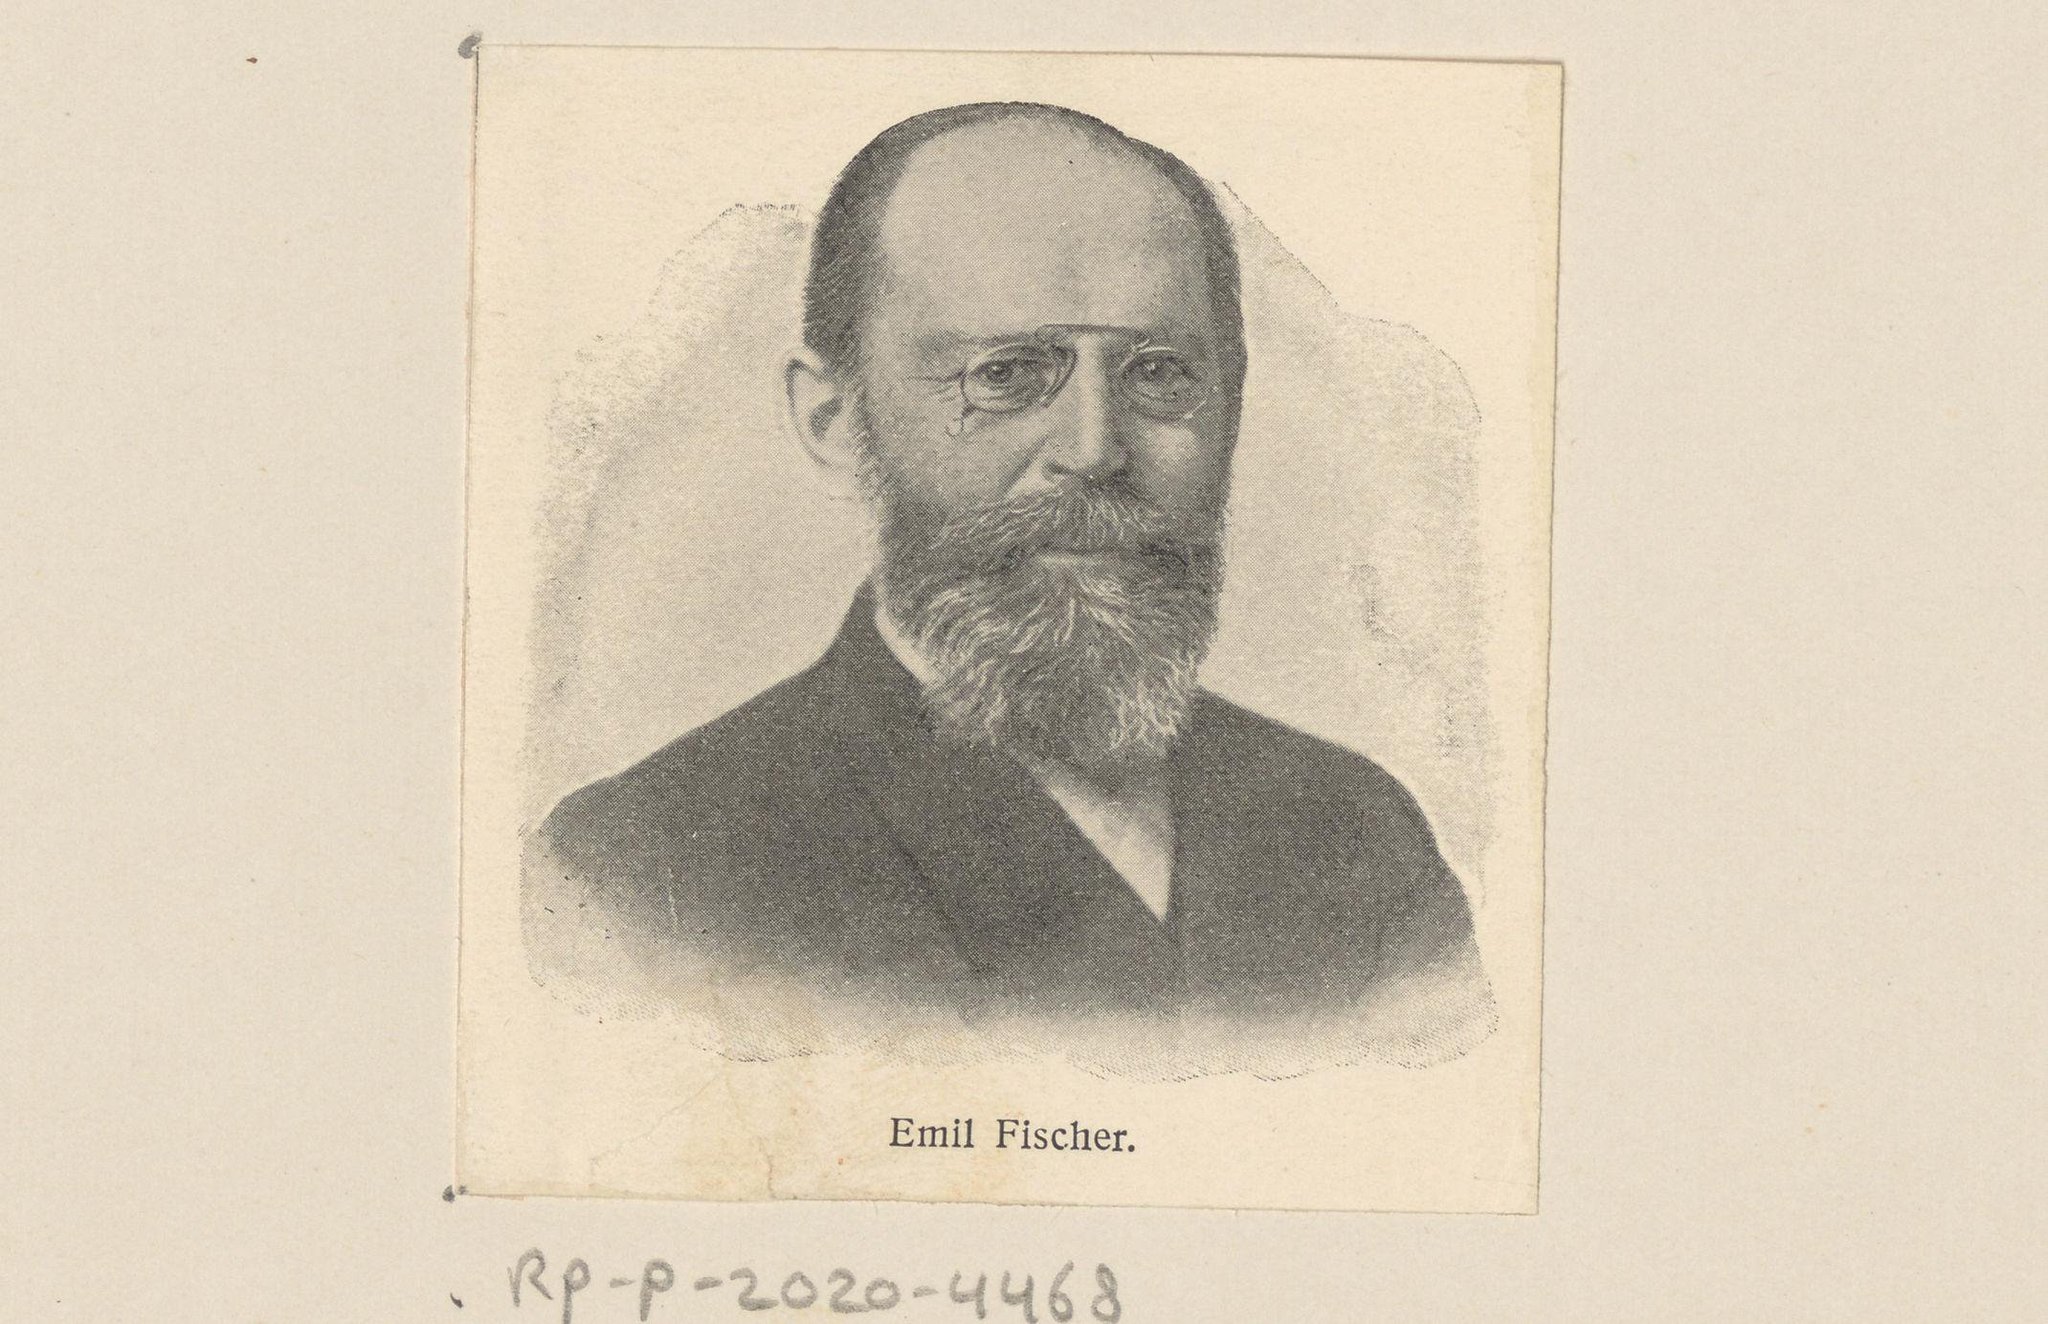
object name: photomechanical print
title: Portret van Hermann Emil Fischer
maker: Anonymous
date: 1895-1900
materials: paper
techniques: autotype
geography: germany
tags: historical persons